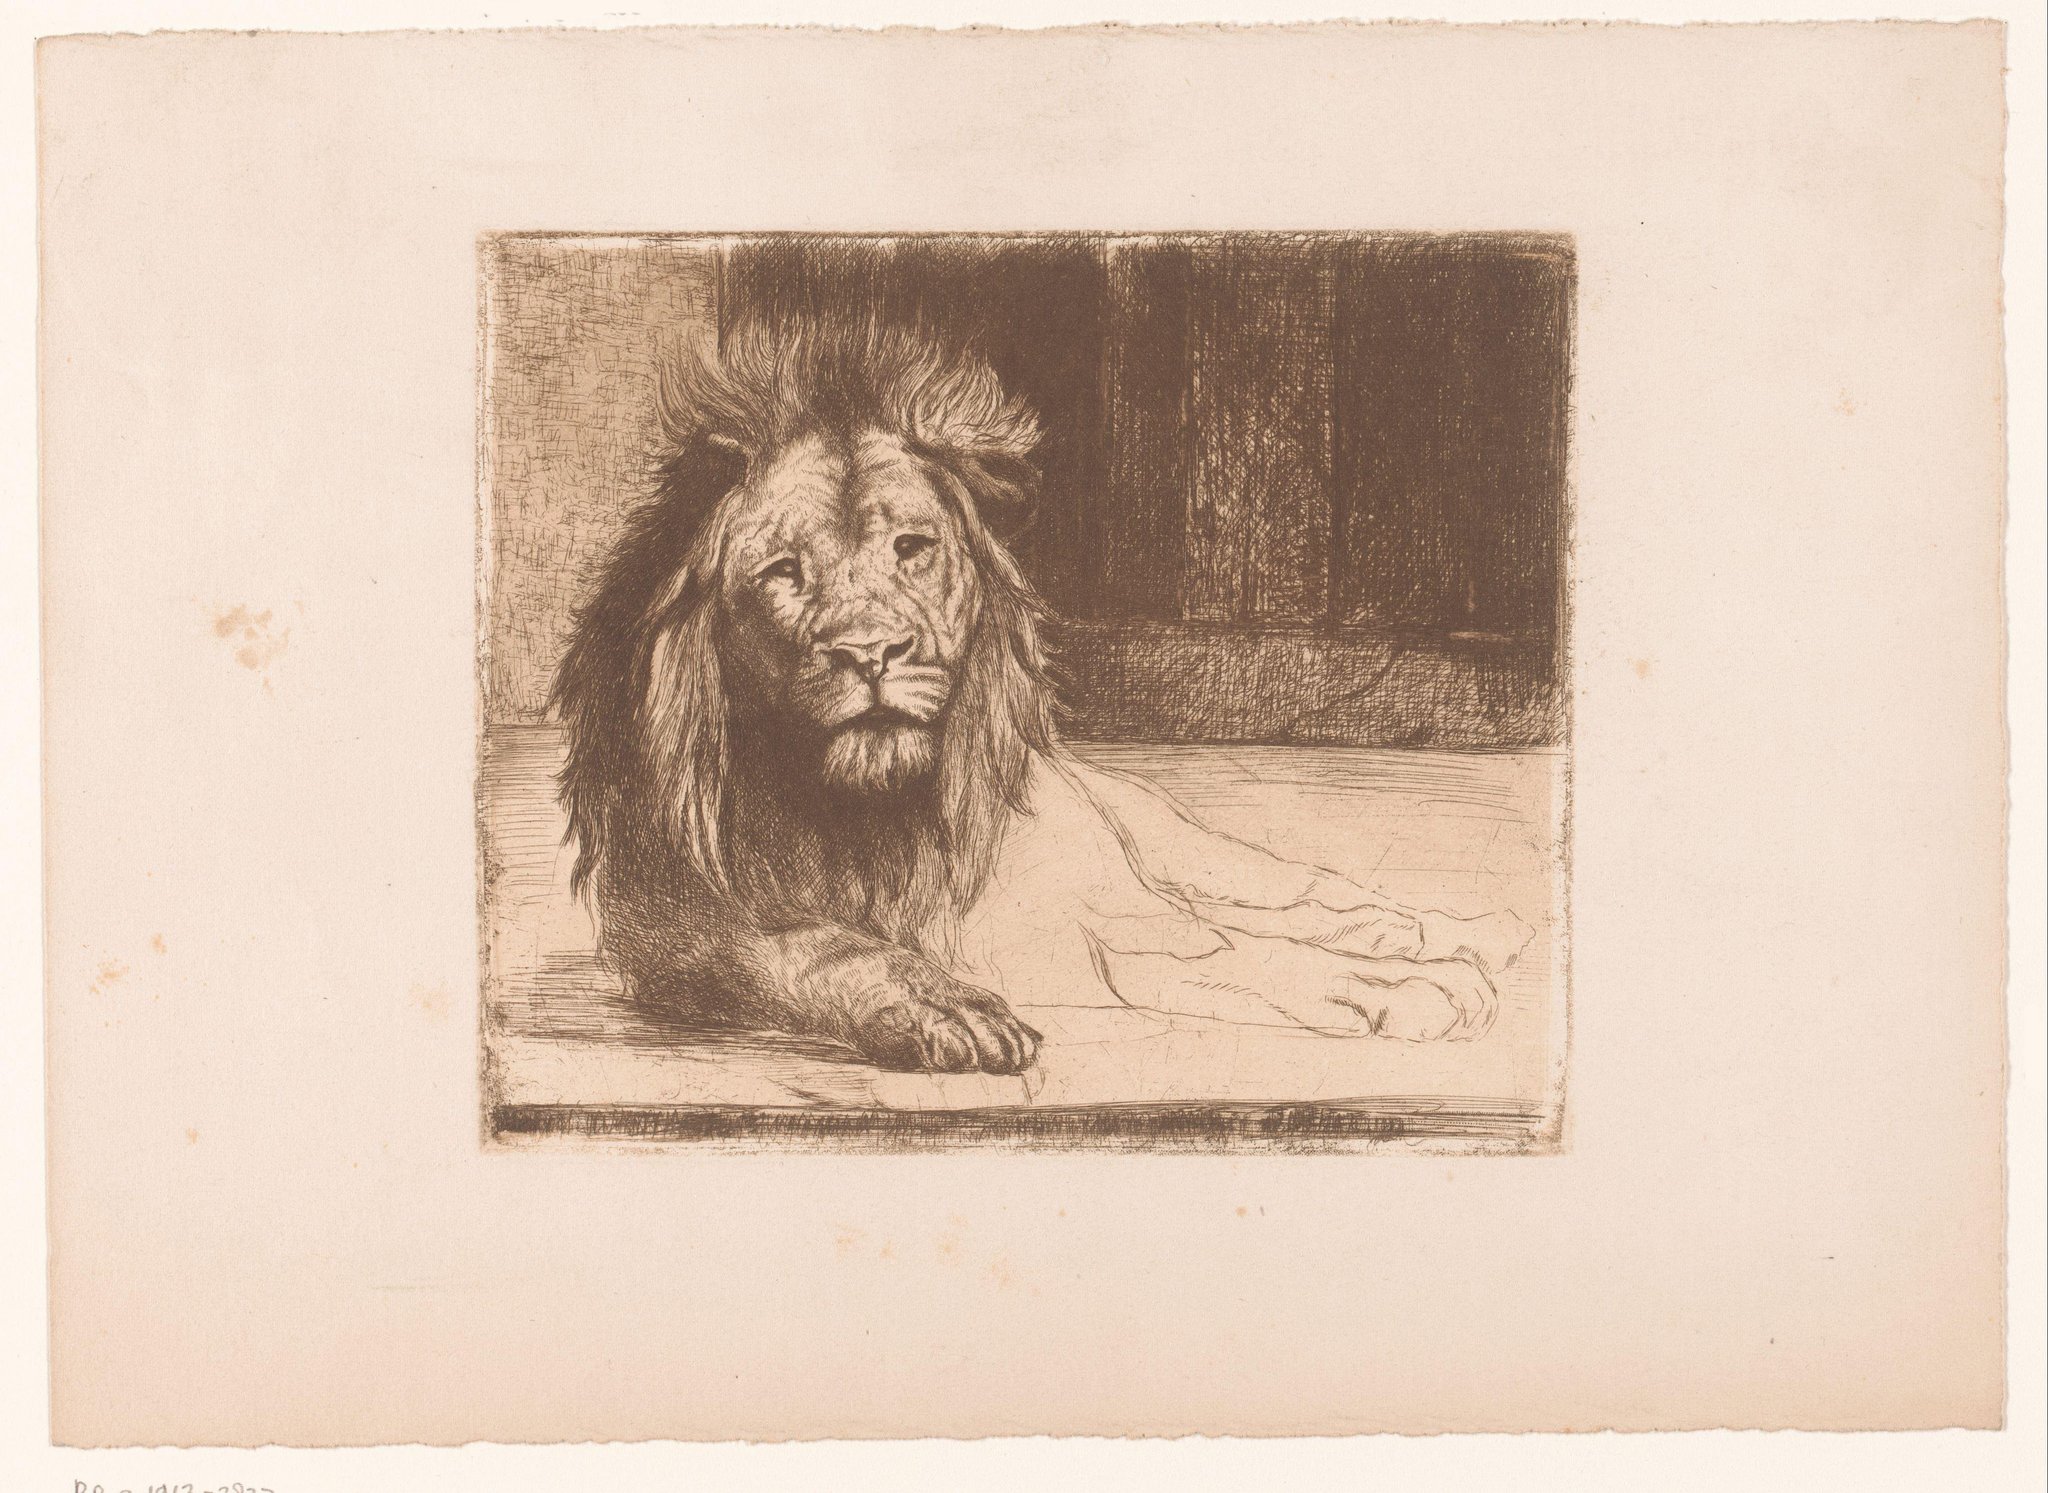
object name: print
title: Liggende leeuw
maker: joseph schippers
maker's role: print maker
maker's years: 1868-1950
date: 1894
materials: paper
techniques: etching, intaglio, roulette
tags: beasts of prey, predatory animals: lion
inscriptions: collector's mark: Lugt 2228